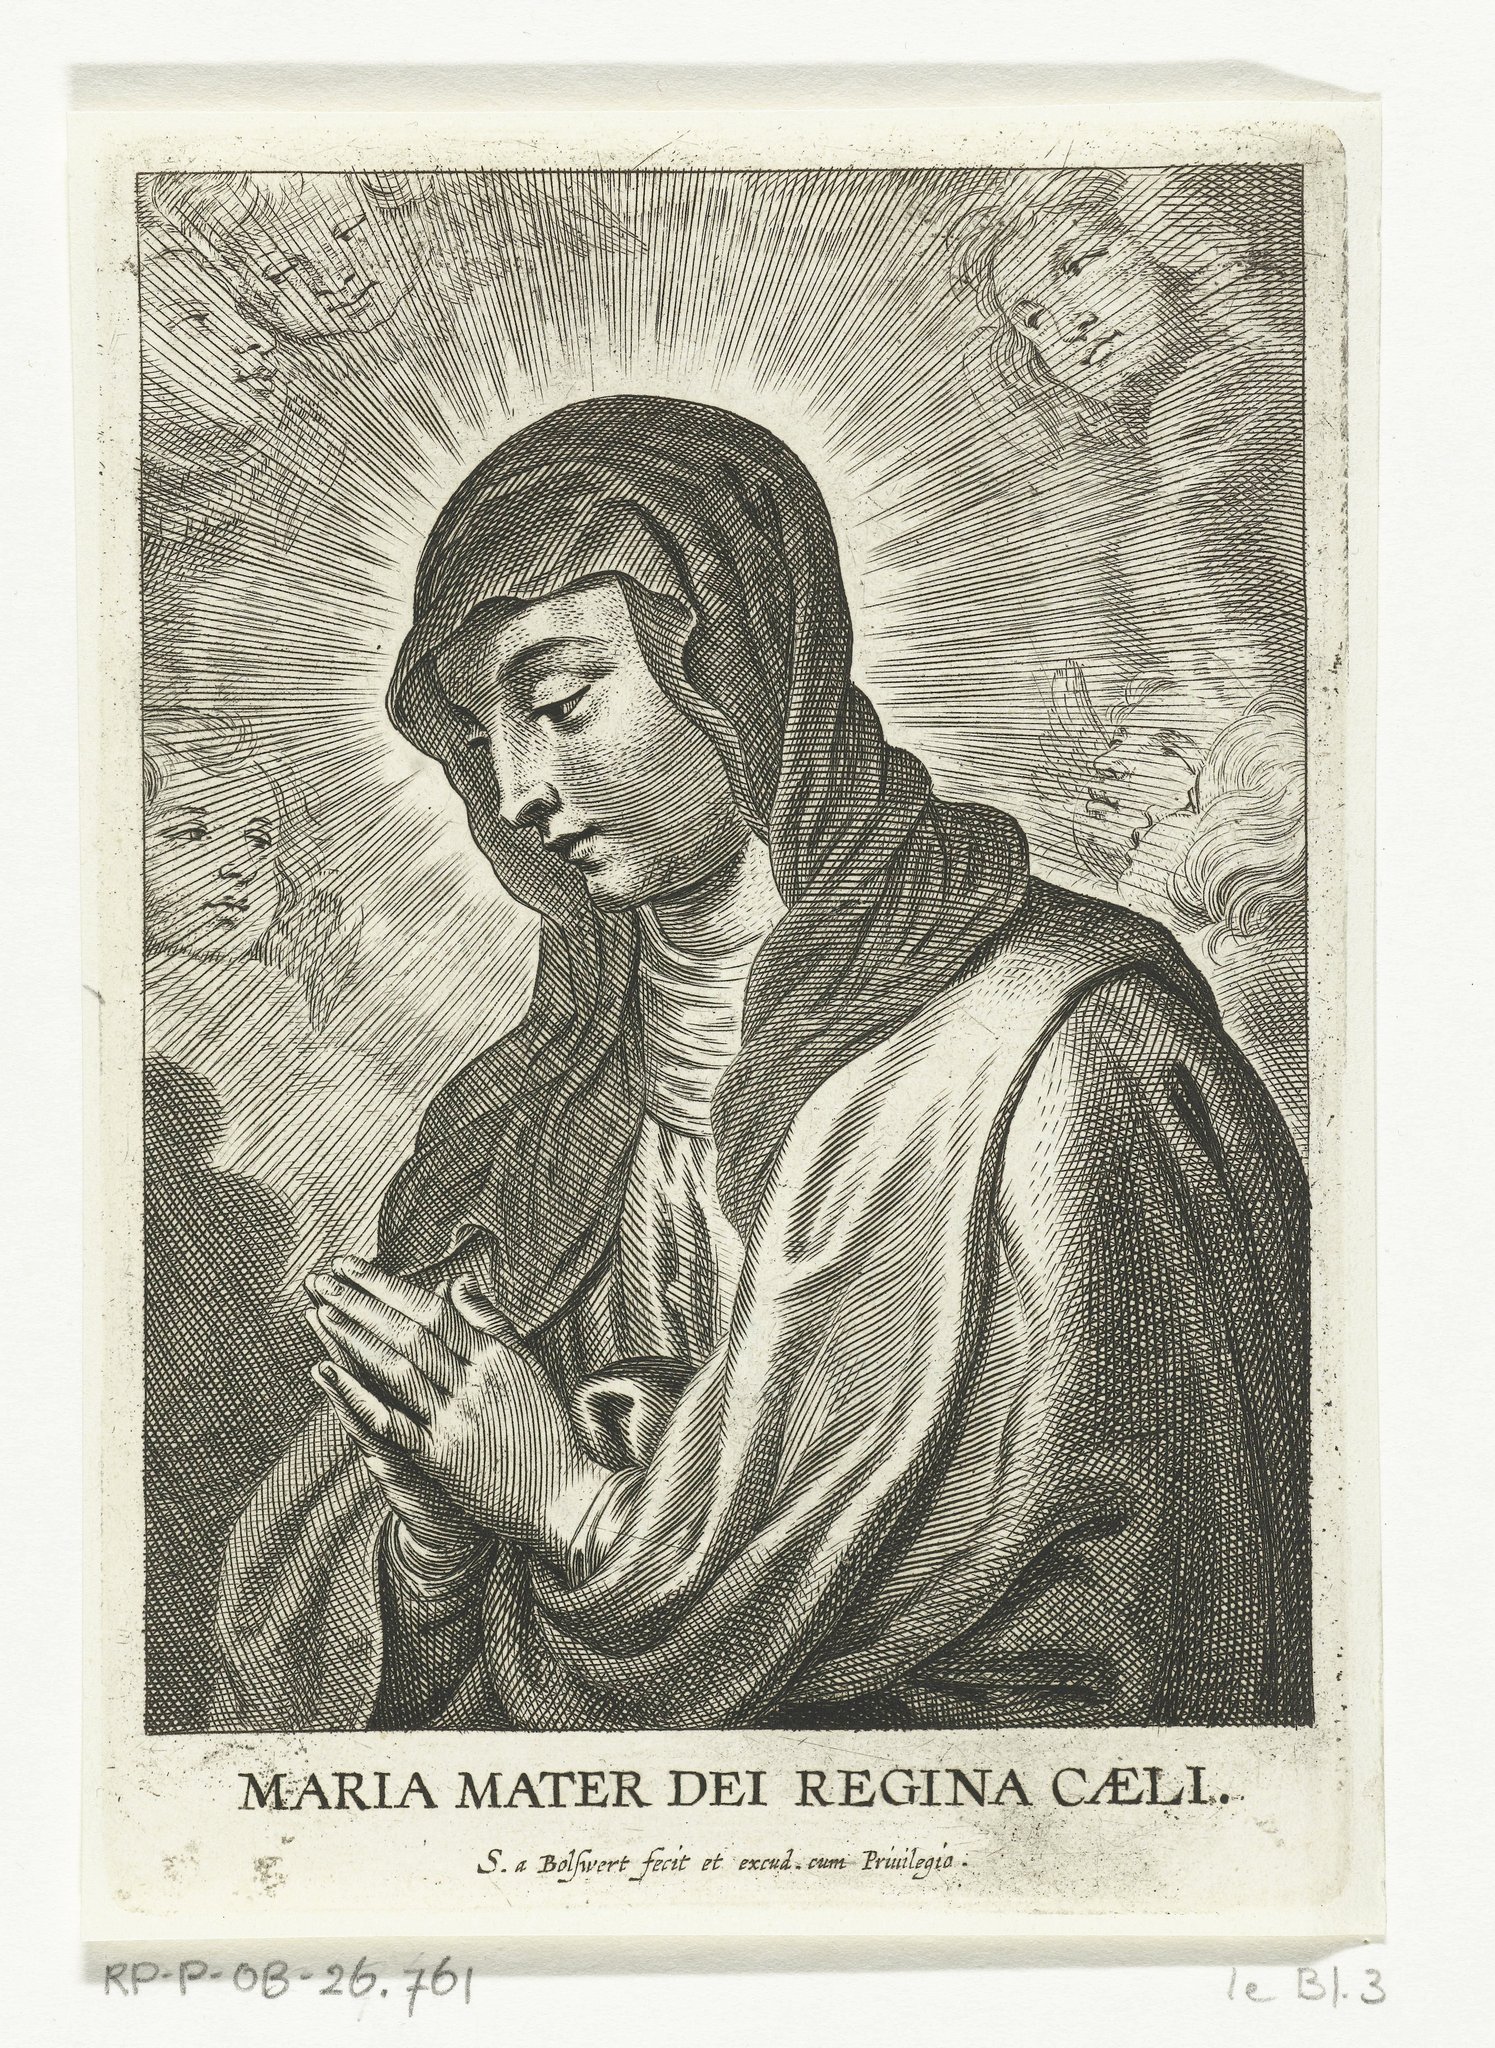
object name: print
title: Maria met gevouwen handen, omringd door cherubijntjes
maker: schelte adamsz. bolswert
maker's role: print maker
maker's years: 1586-1659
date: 1596-1659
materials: paper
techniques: engraving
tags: mary (without the christ-child), 'regina coeli', 'regina angelorum', 'maestà' ~ madonna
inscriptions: collector's mark: Lugt 2228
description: Prent uit serie Vélins met negentig prenten naar ontwerp van Peter Paul Rubens. In de bronnen vinden we uiteenlopende gegevens over aantal en samenstelling van de serie. Hollstein hanteert het aantal van negentig prenten. De reeks Vélins in de collectie van het RMA bevat verschillende staten afkomstig uit meerdere uitgaven welke moeilijk te duiden zijn. Sommige dragen het originele adres van Schelte Adamsz. Bolswert als graveur en uitgever, op andere exemplaren is deze naam verwijderd (duidelijk zichtbaar!) en vervangen door de naam Cornelis Galle (II). De prenten met de naam van uitgever Galle zijn vaak opgewerkt. We treffen nog een andere naam van een uitgever bij enkele prent aan: Martien van den Enden. Herkomst uit meerdere uitgaven spreekt ook uit afwijkende opschriften in Nederlands en Latijn en variaties op dezelfde thema's welke misschien nooit langs elkaar in dezelfde serie gebruikt werden.